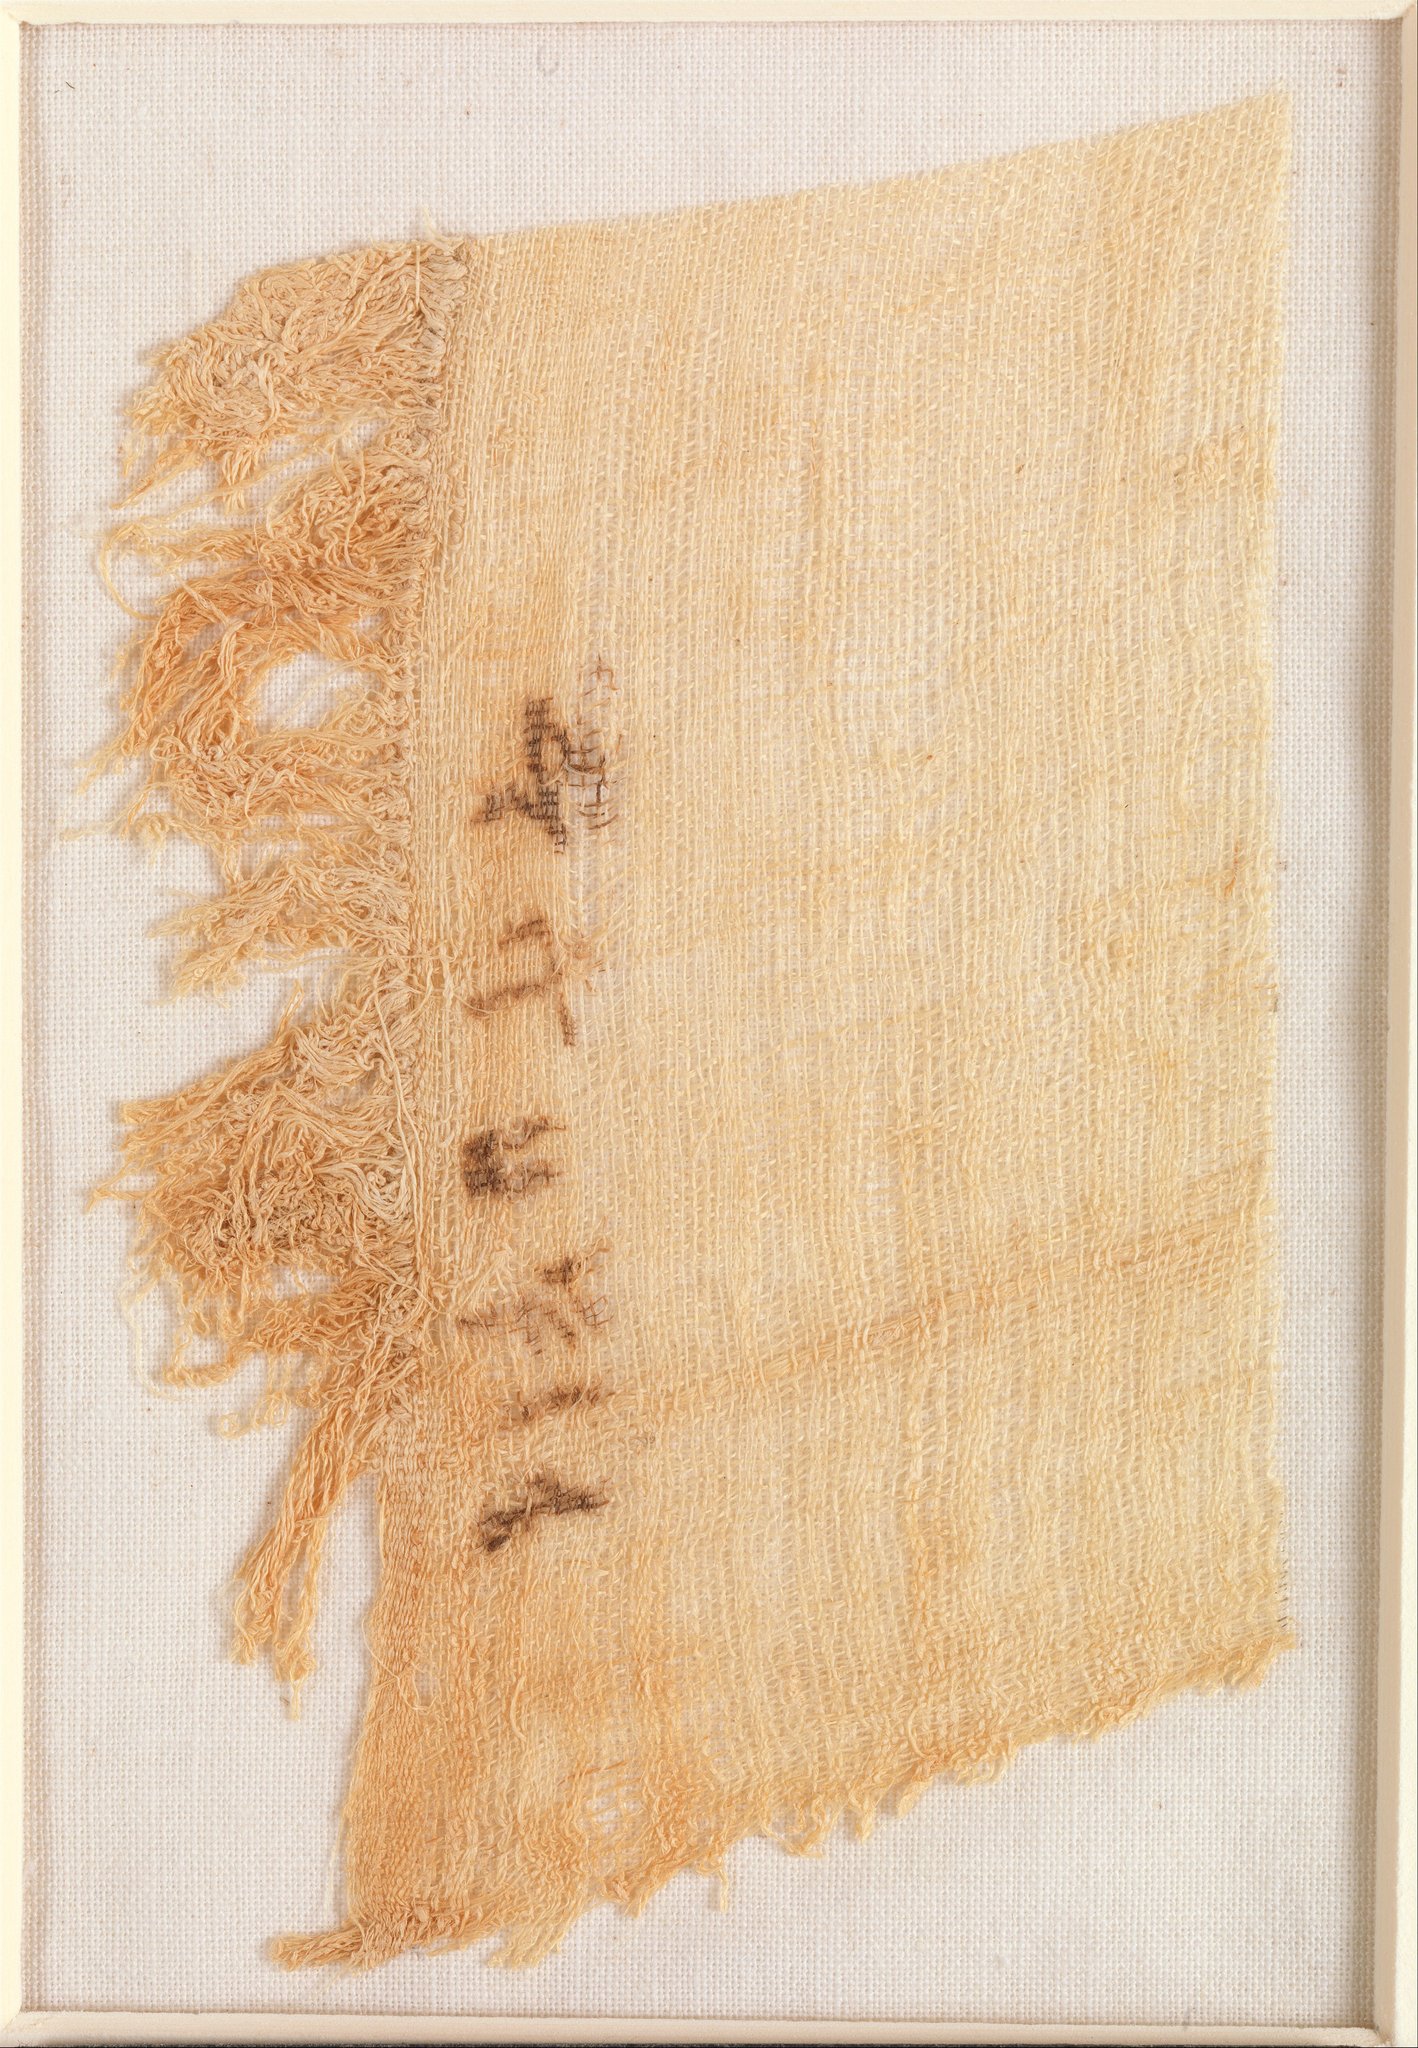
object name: linen mark, wah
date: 1981-1975 BCE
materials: linen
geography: egypt